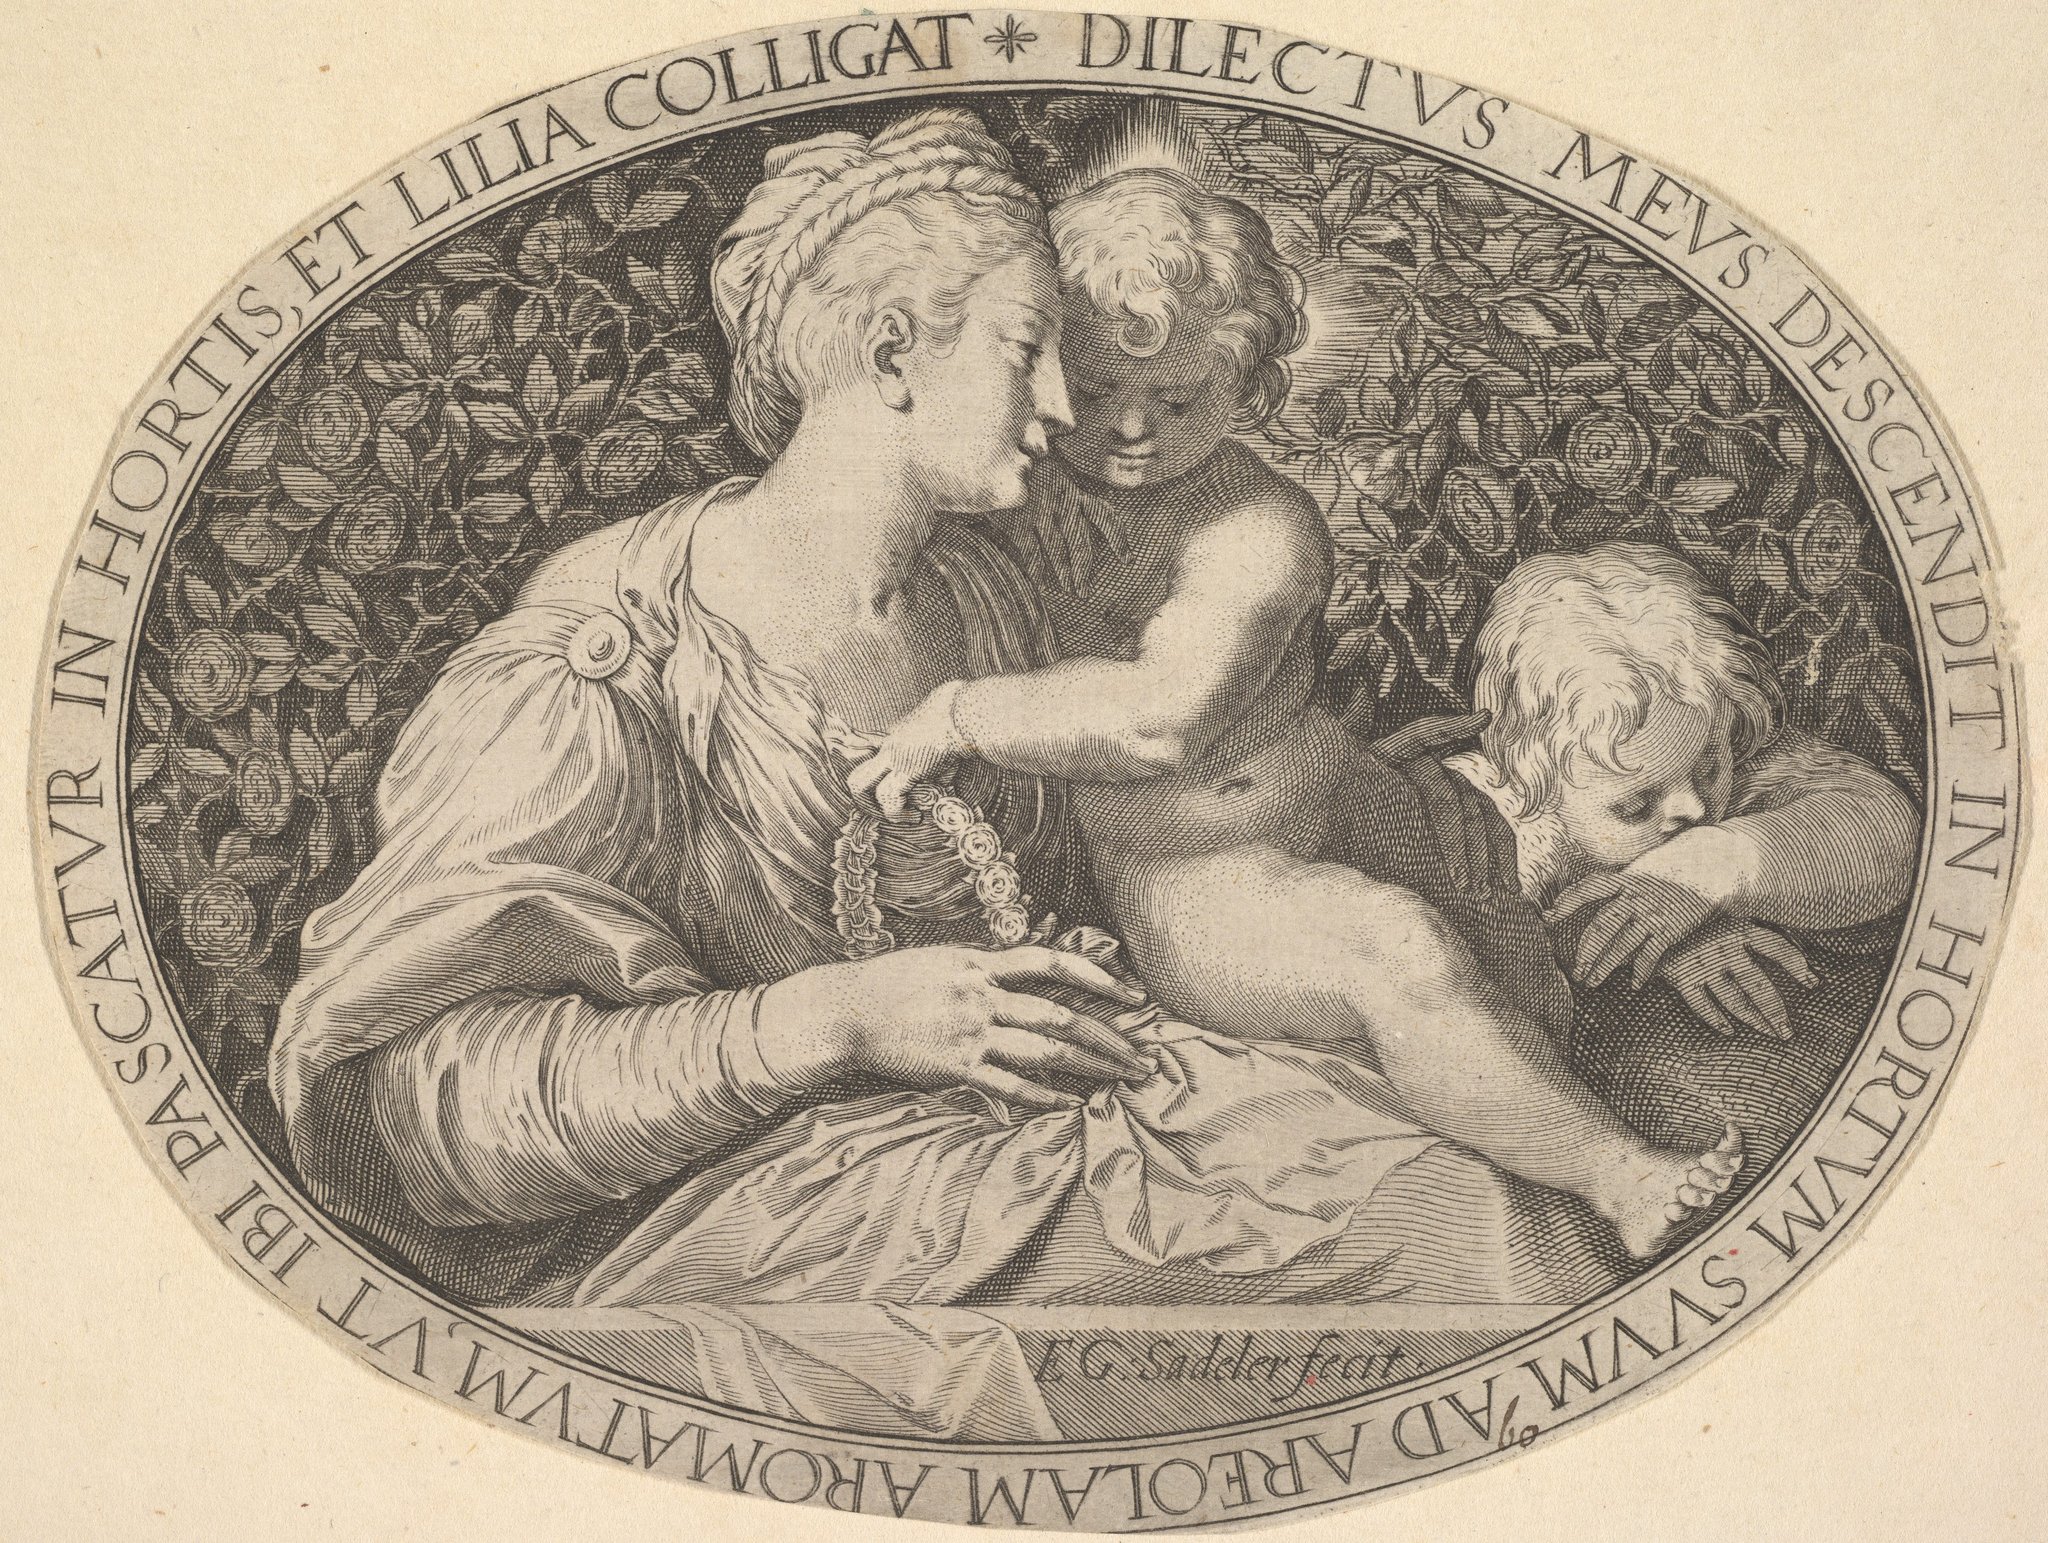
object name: print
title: Madonna and Child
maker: aegidius sadeler (ii)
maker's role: artist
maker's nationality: flemish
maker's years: 1568-1629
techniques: engraving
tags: roses,madonna and child